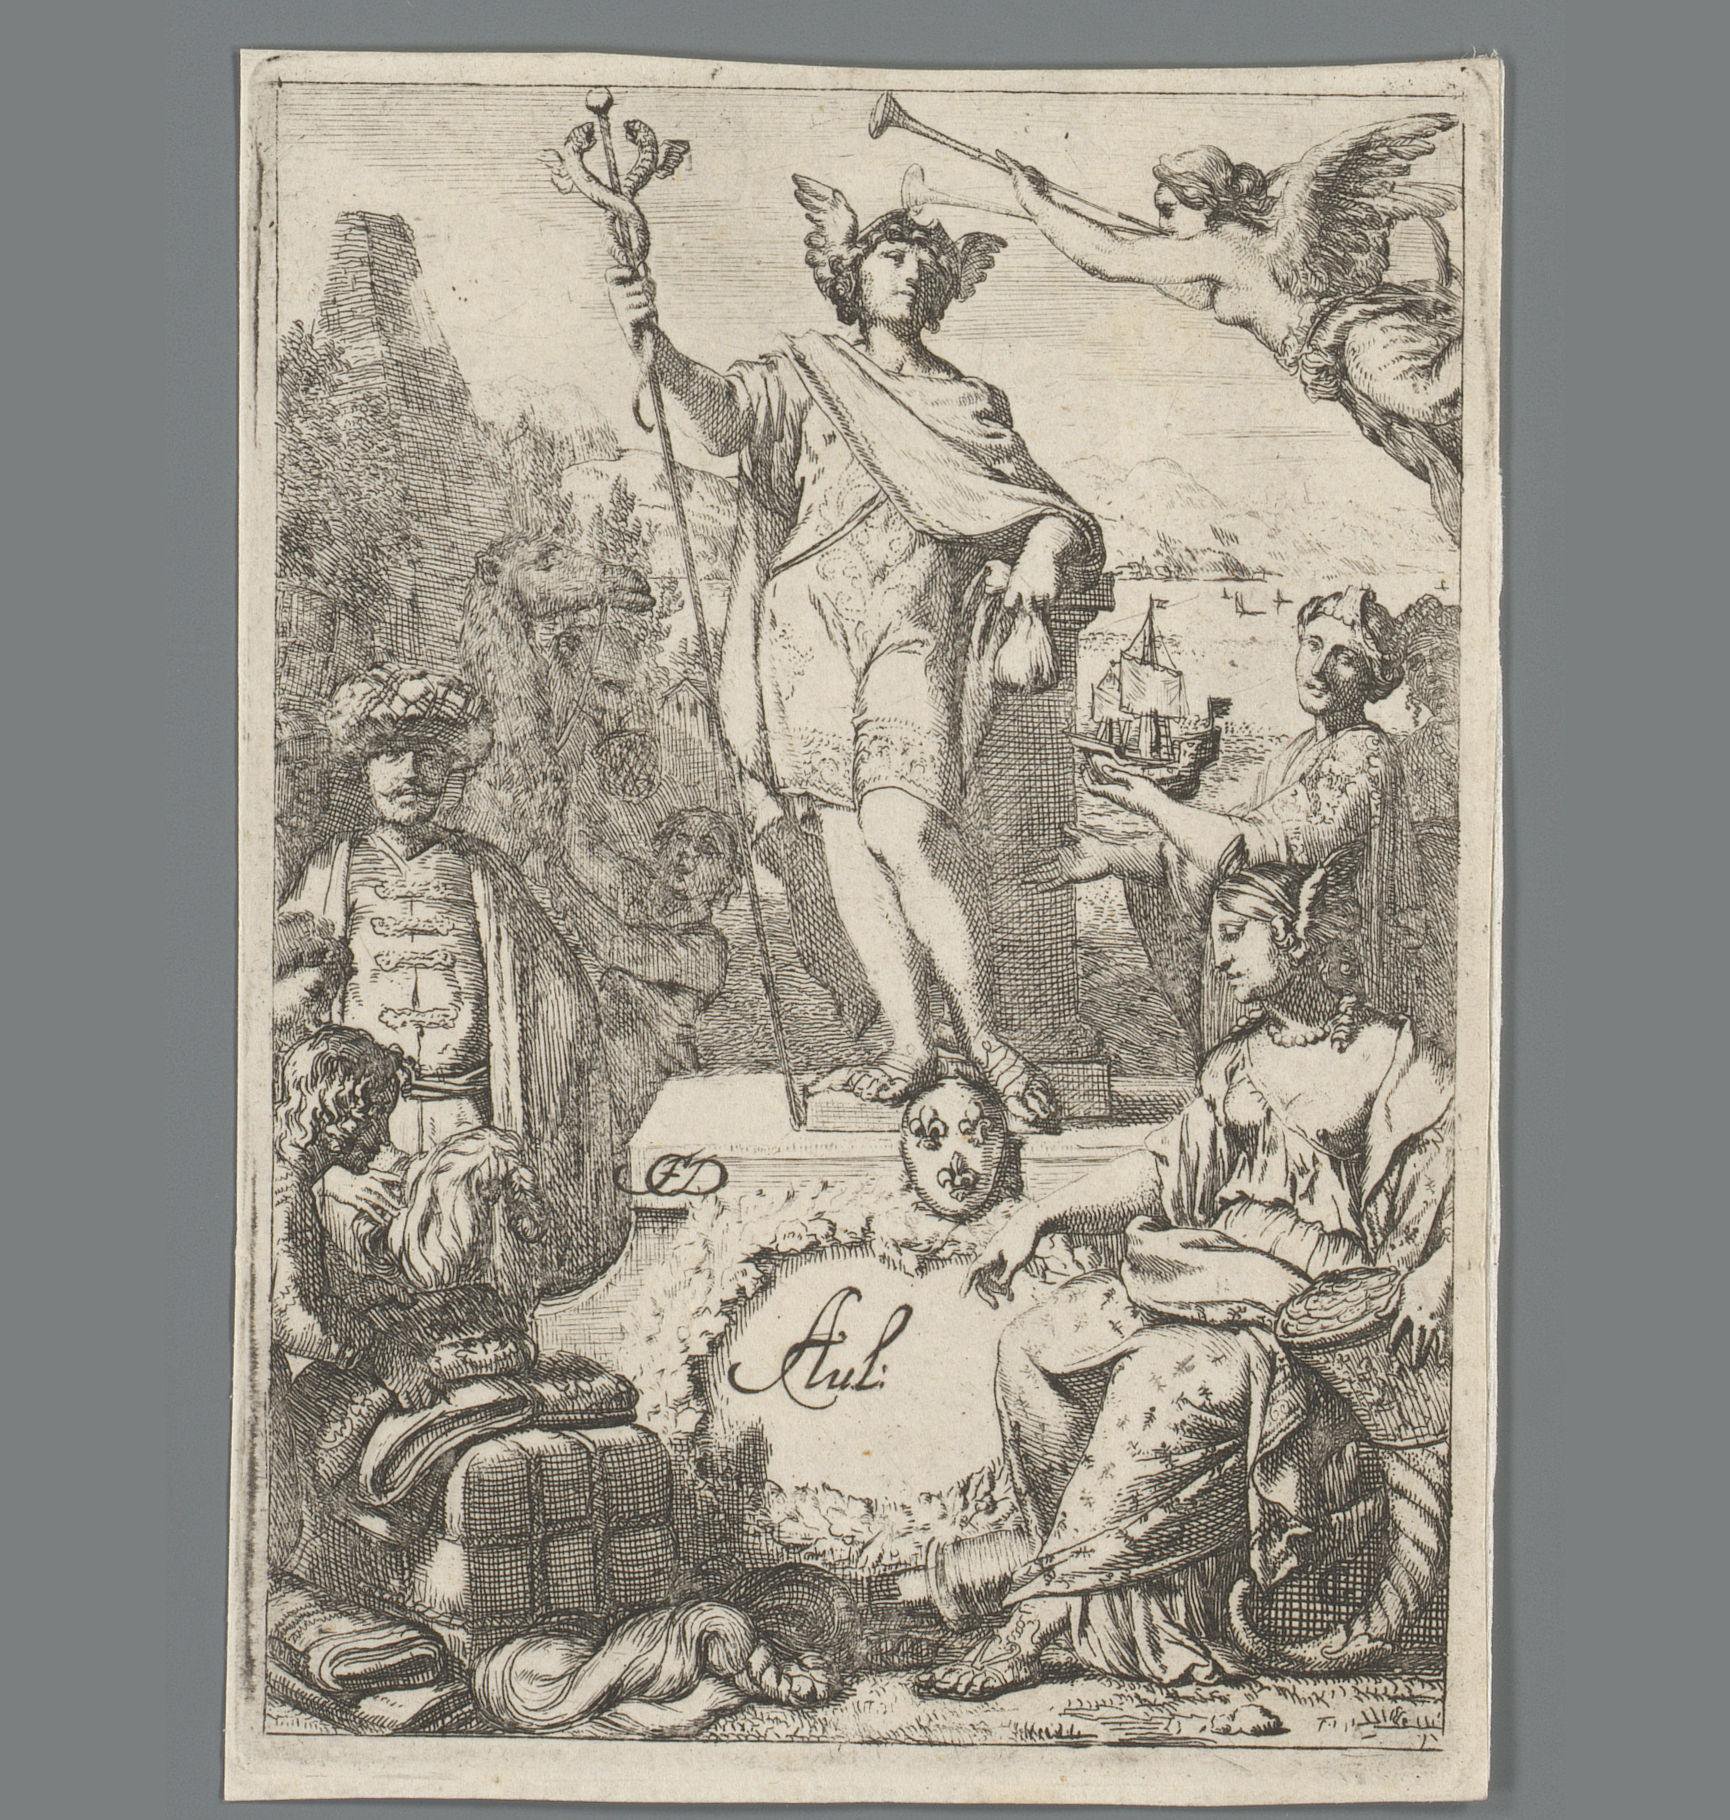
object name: print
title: Allegorie op de handel met Mercurius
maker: Anonymous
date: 1600-1699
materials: paper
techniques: engraving, etching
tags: hoofed animals: camel, (story of) mercury (hermes), allegory of trade; 'commertio della vita humana' (ripa), labour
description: Mercurius staat op een voetstuk dat versierd is met het wapen van Frankrijk, de bazuin blazende Faam vliegt naast zijn hoofd. Op de voorgrond zit rechts de personificatie van Arbeid en Vlijt, gehuld in een kleed bezet met mieren. Ze wijst op een met krans omgeven ovaal met het opschrift 'Avl', in haar linkerhand houdt ze een met geld gevulde cornucopia vast. Links staat een koopman bij stoffen en verpakte handelswaar, achter hem wachten twee kamelen.